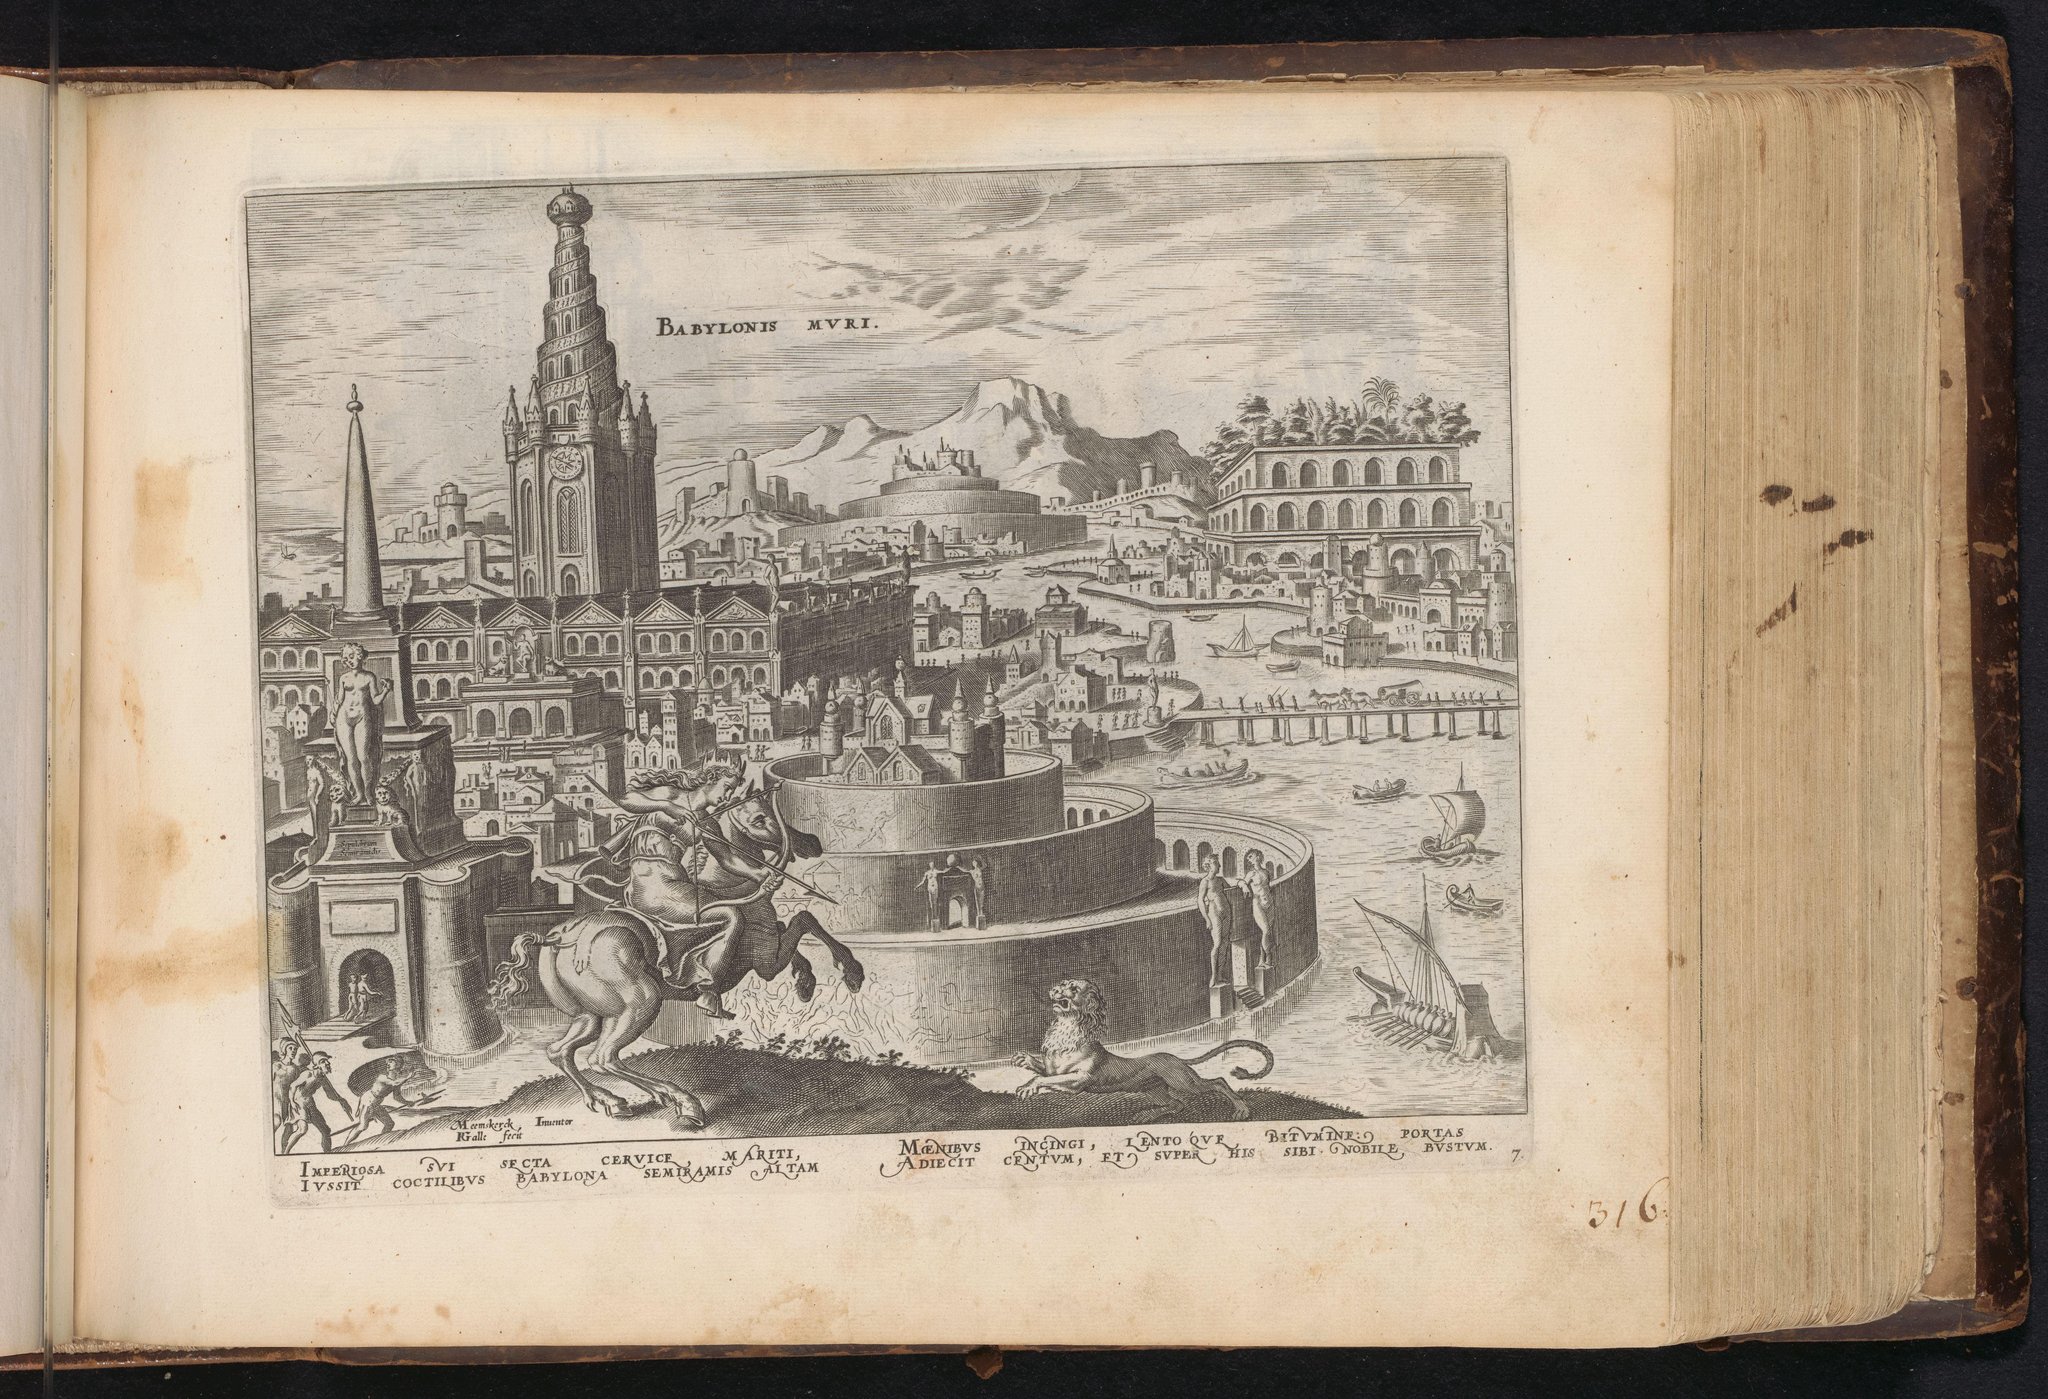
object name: album leaf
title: De acht wereldwonderen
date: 1572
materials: paper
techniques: engraving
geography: alkmaar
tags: semiramis on the lion-hunt, sometimes with her husband ninus, hanging gardens of semiramis at babylon (wonder of the world)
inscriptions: number: ‘316’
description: De muren van Babylon, in cirkels gebouwd. Linksachter een groot gebouw met toren. Op de voorgrond koningin Semiramis als een amazone te paard. Gewapend met pijl en boog is zij is in gevecht met een leeuw. In de achtergrond de hangende tuinen van Babylon: een botanisch en architectonisch kunstwerk. Onder de voorstelling een vers in het Latijn. Deze prent maakt deel uit van een album.